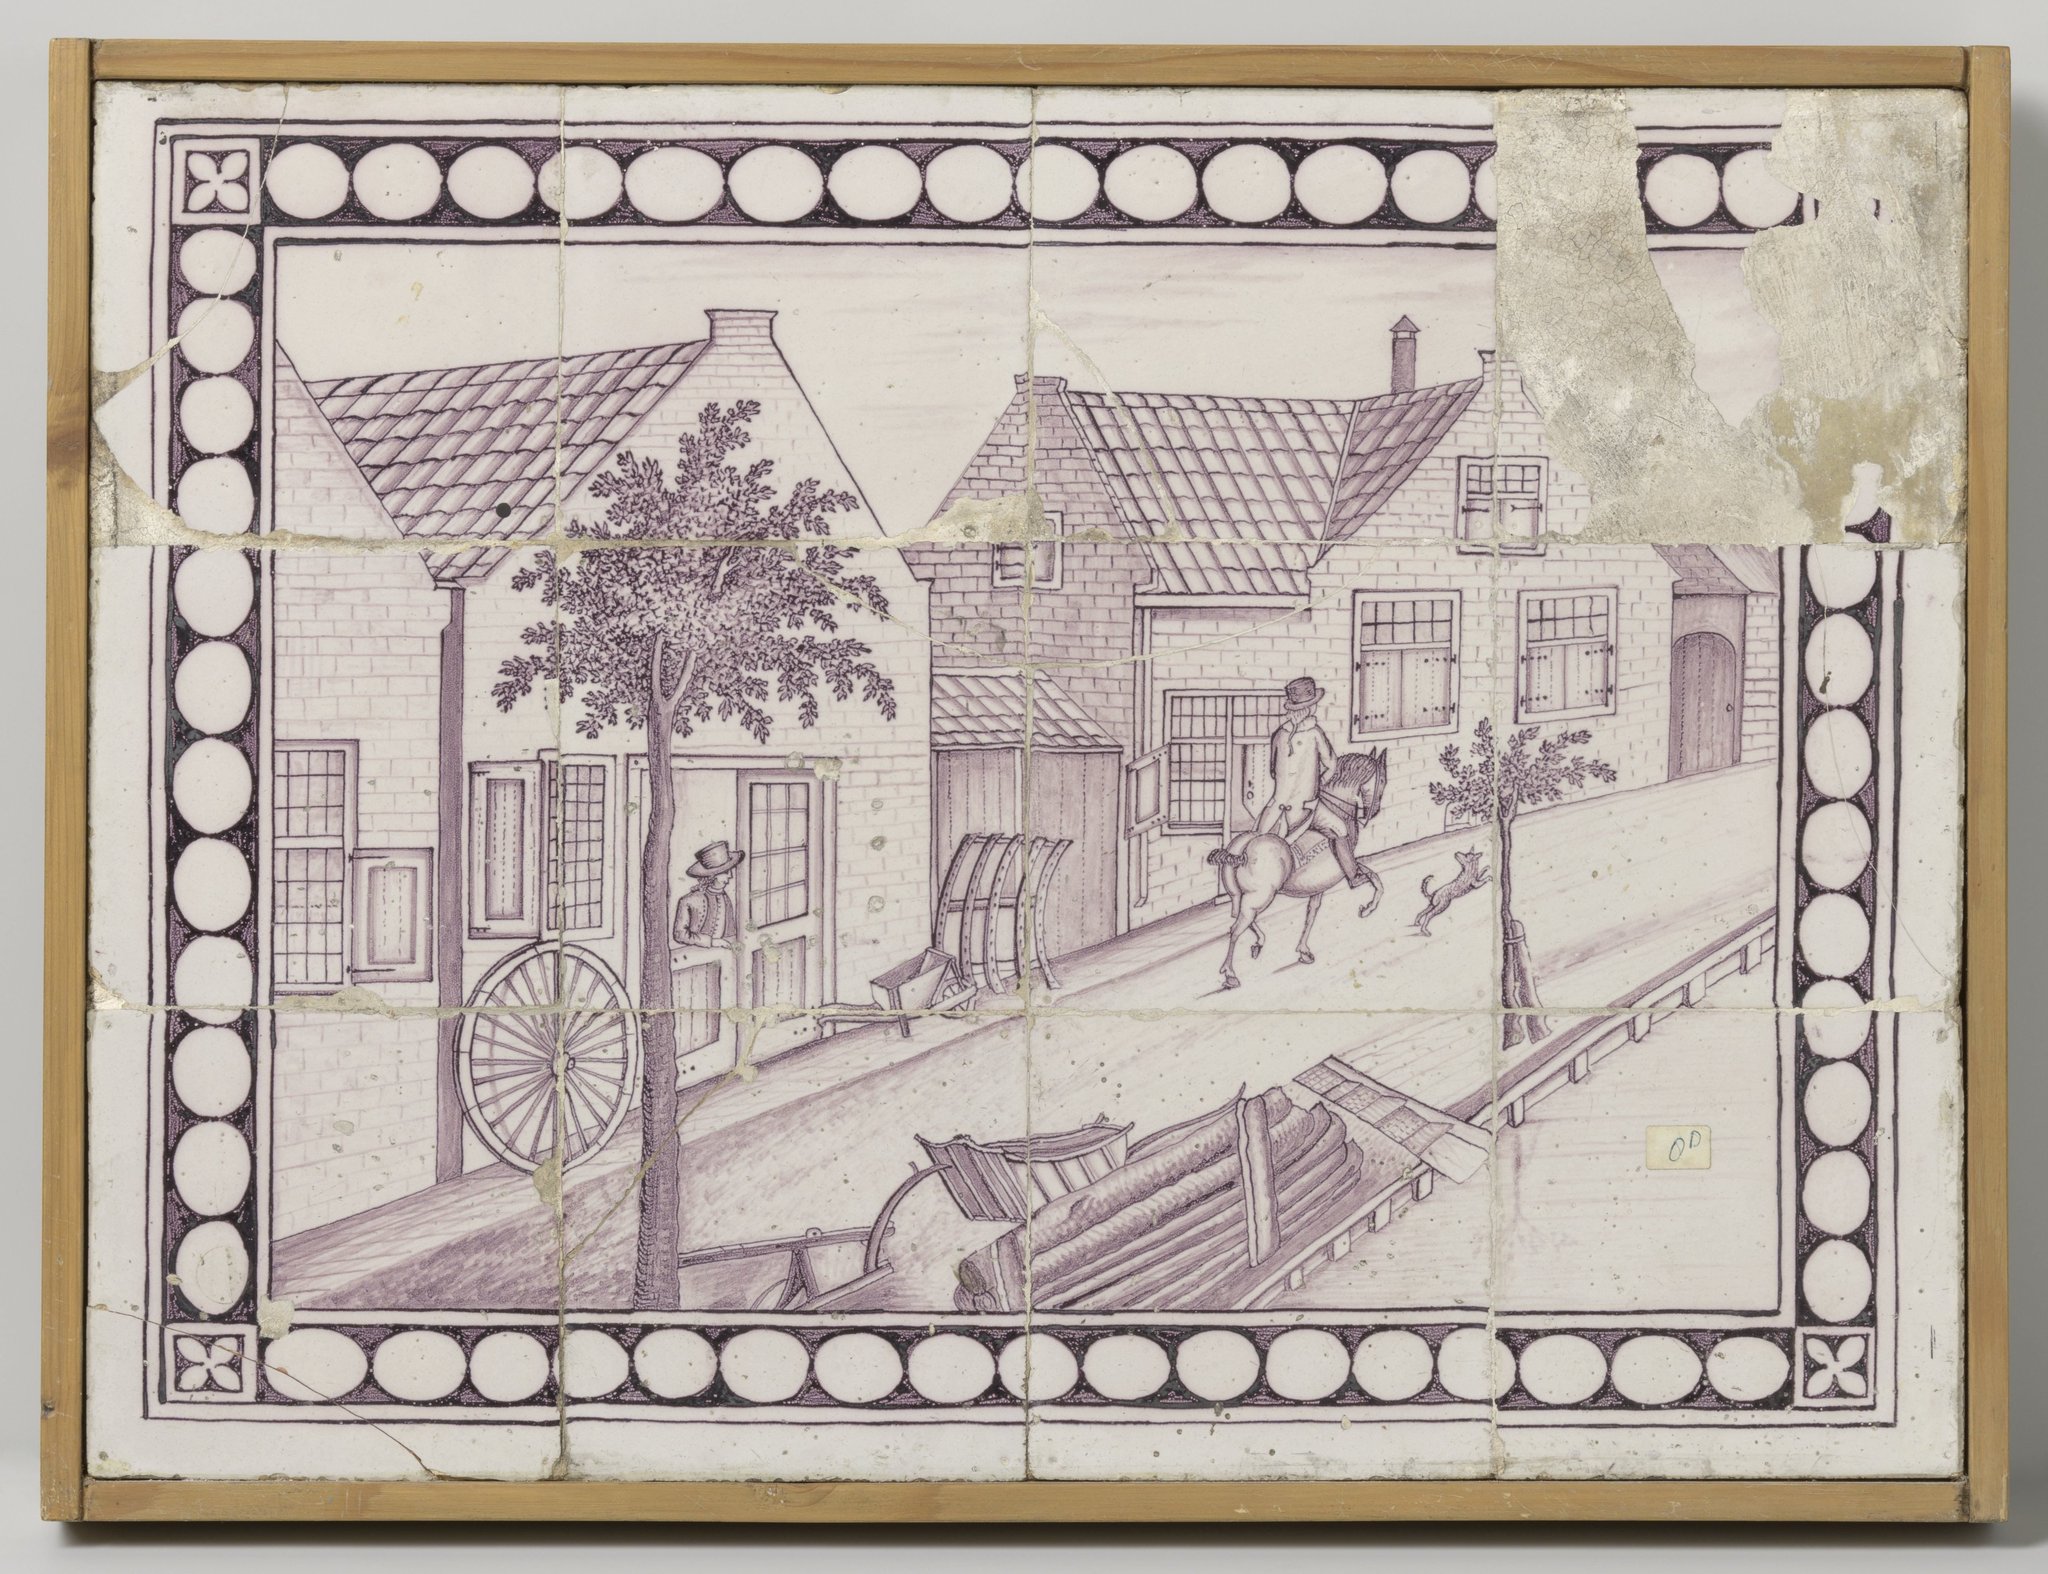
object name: tile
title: Tegeltableau van twaalf tegels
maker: Anonymous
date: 1775-1825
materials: earthenware, glaze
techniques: maiolica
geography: netherlands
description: Tegeltableau van 12 tegels (3 x 4) met een paars geschilderde voorstelling van een werkplaats waar rijtuigen worden gemaakt van de straatkant gezien. De voorstelling is omgeven door een eierlijst met rozetten in de hoeken. Zie pendant: BK-NM-5197.